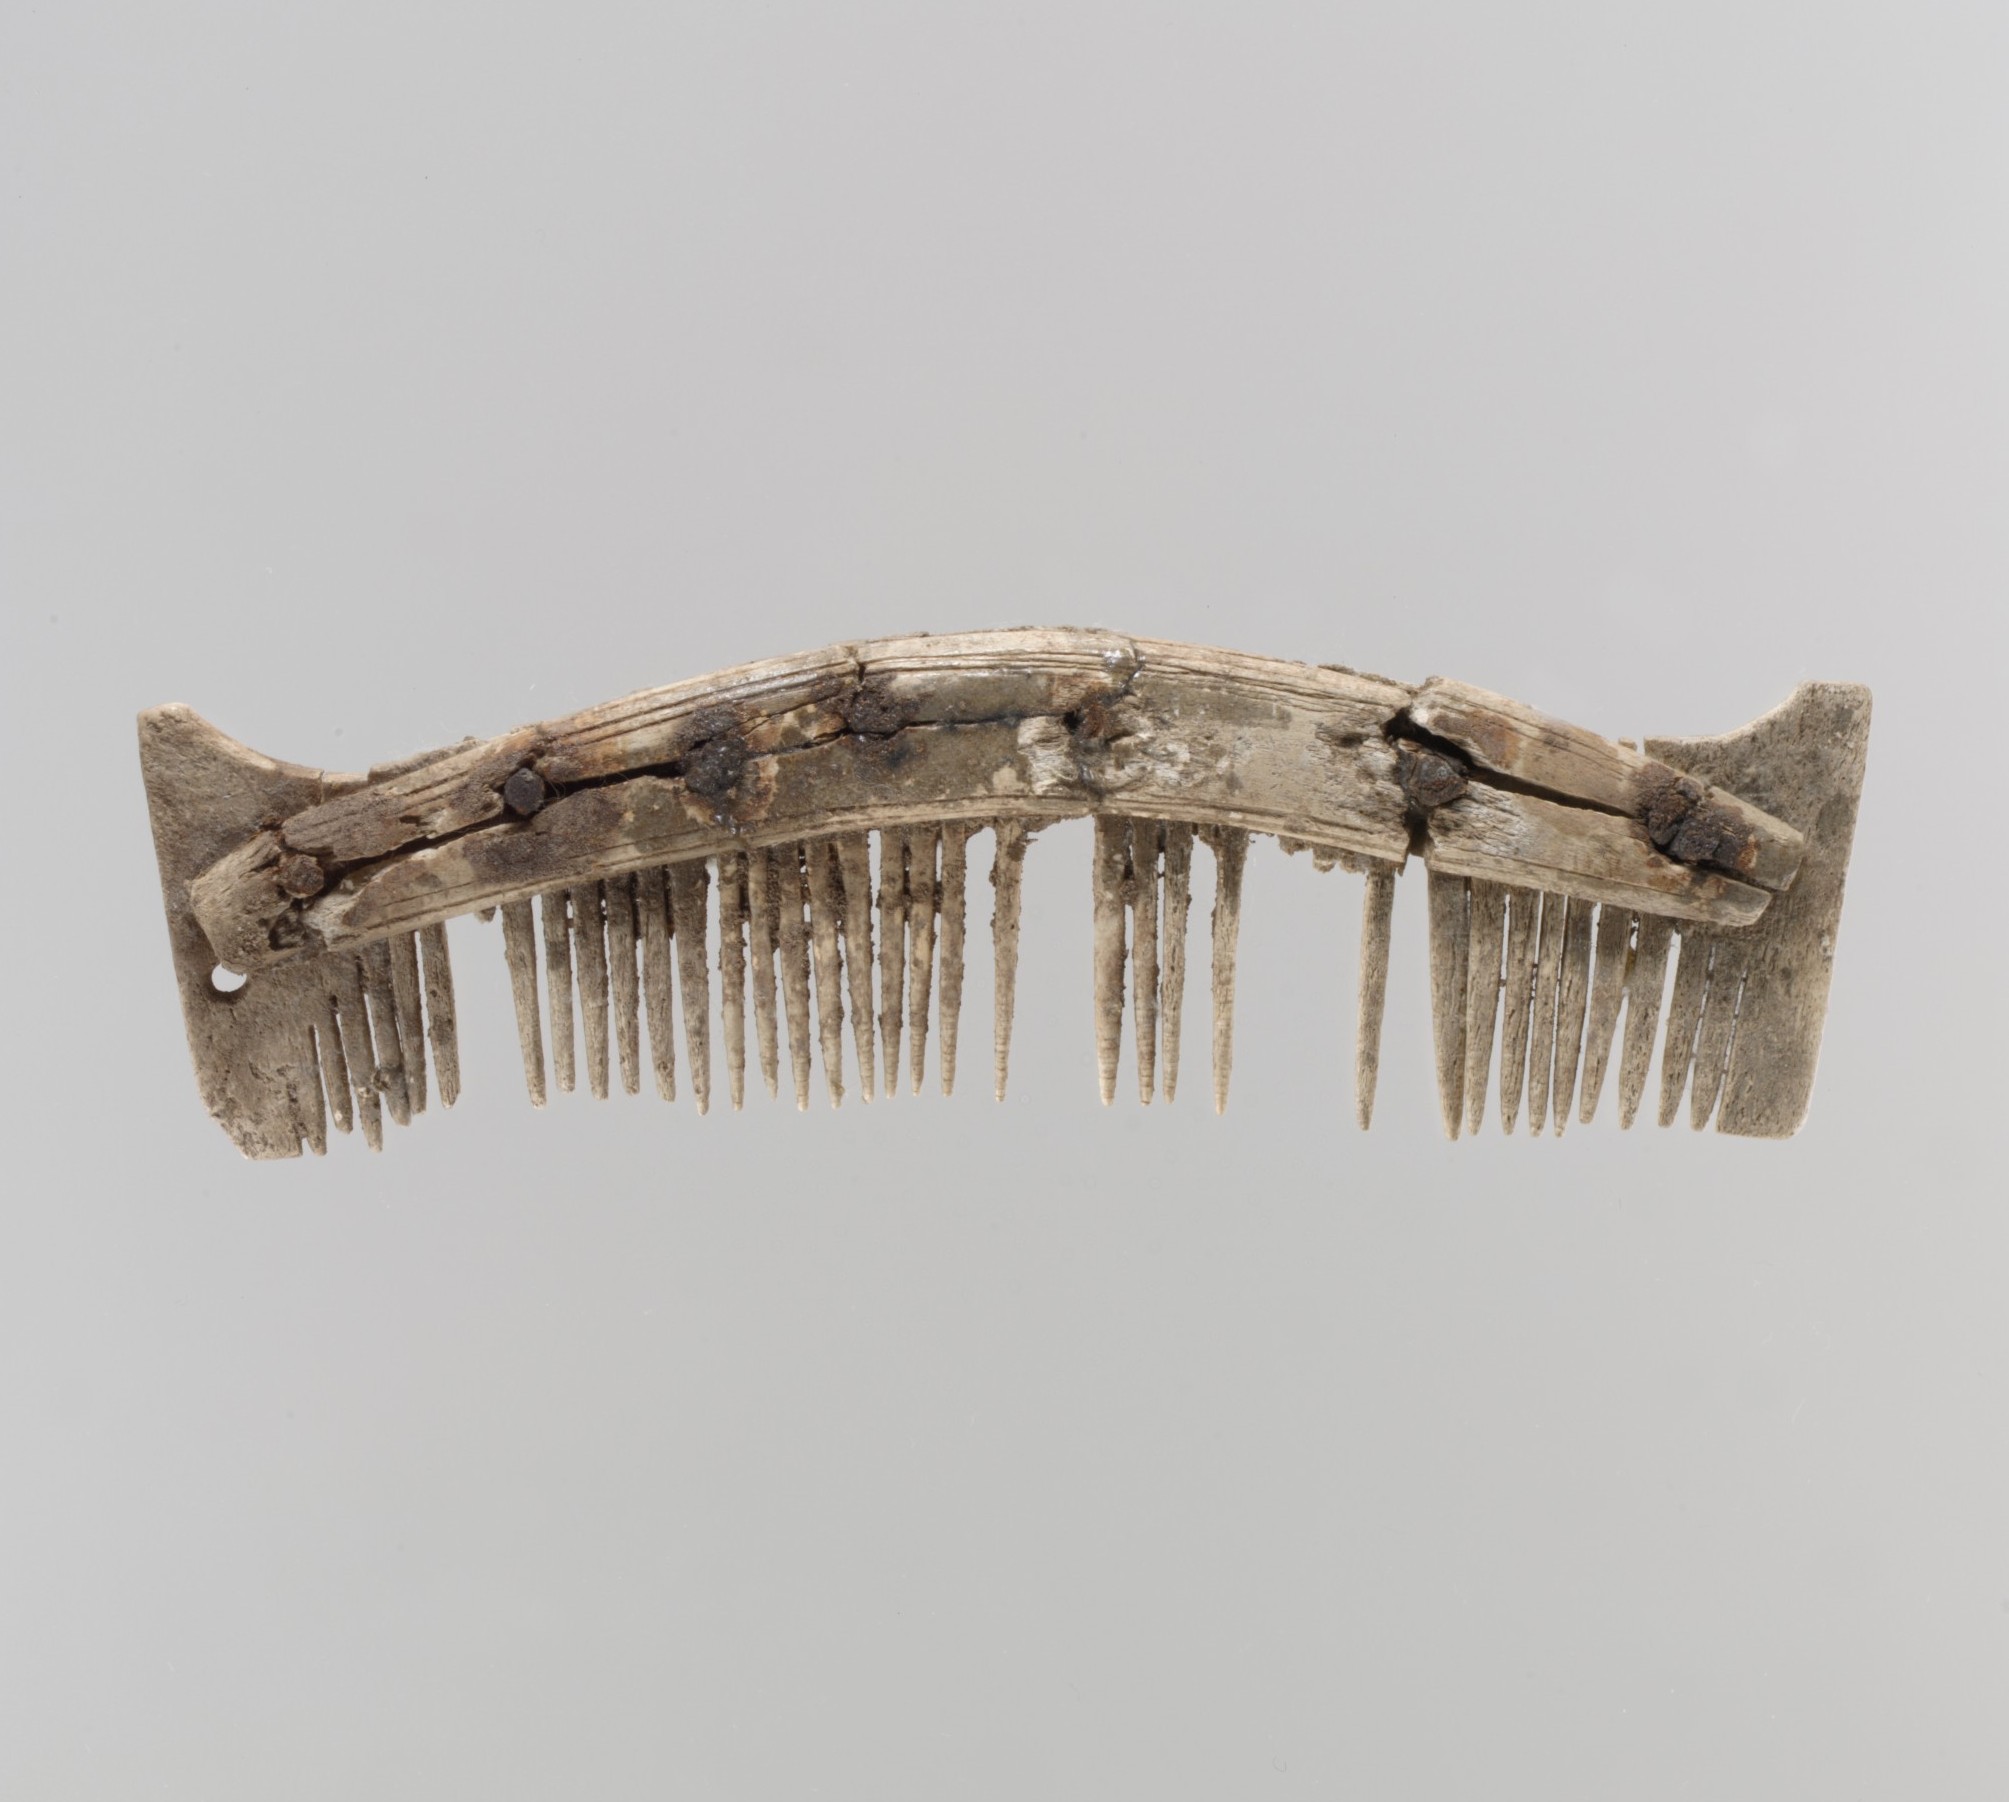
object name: comb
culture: frankish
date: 501-600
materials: bone, iron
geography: germany